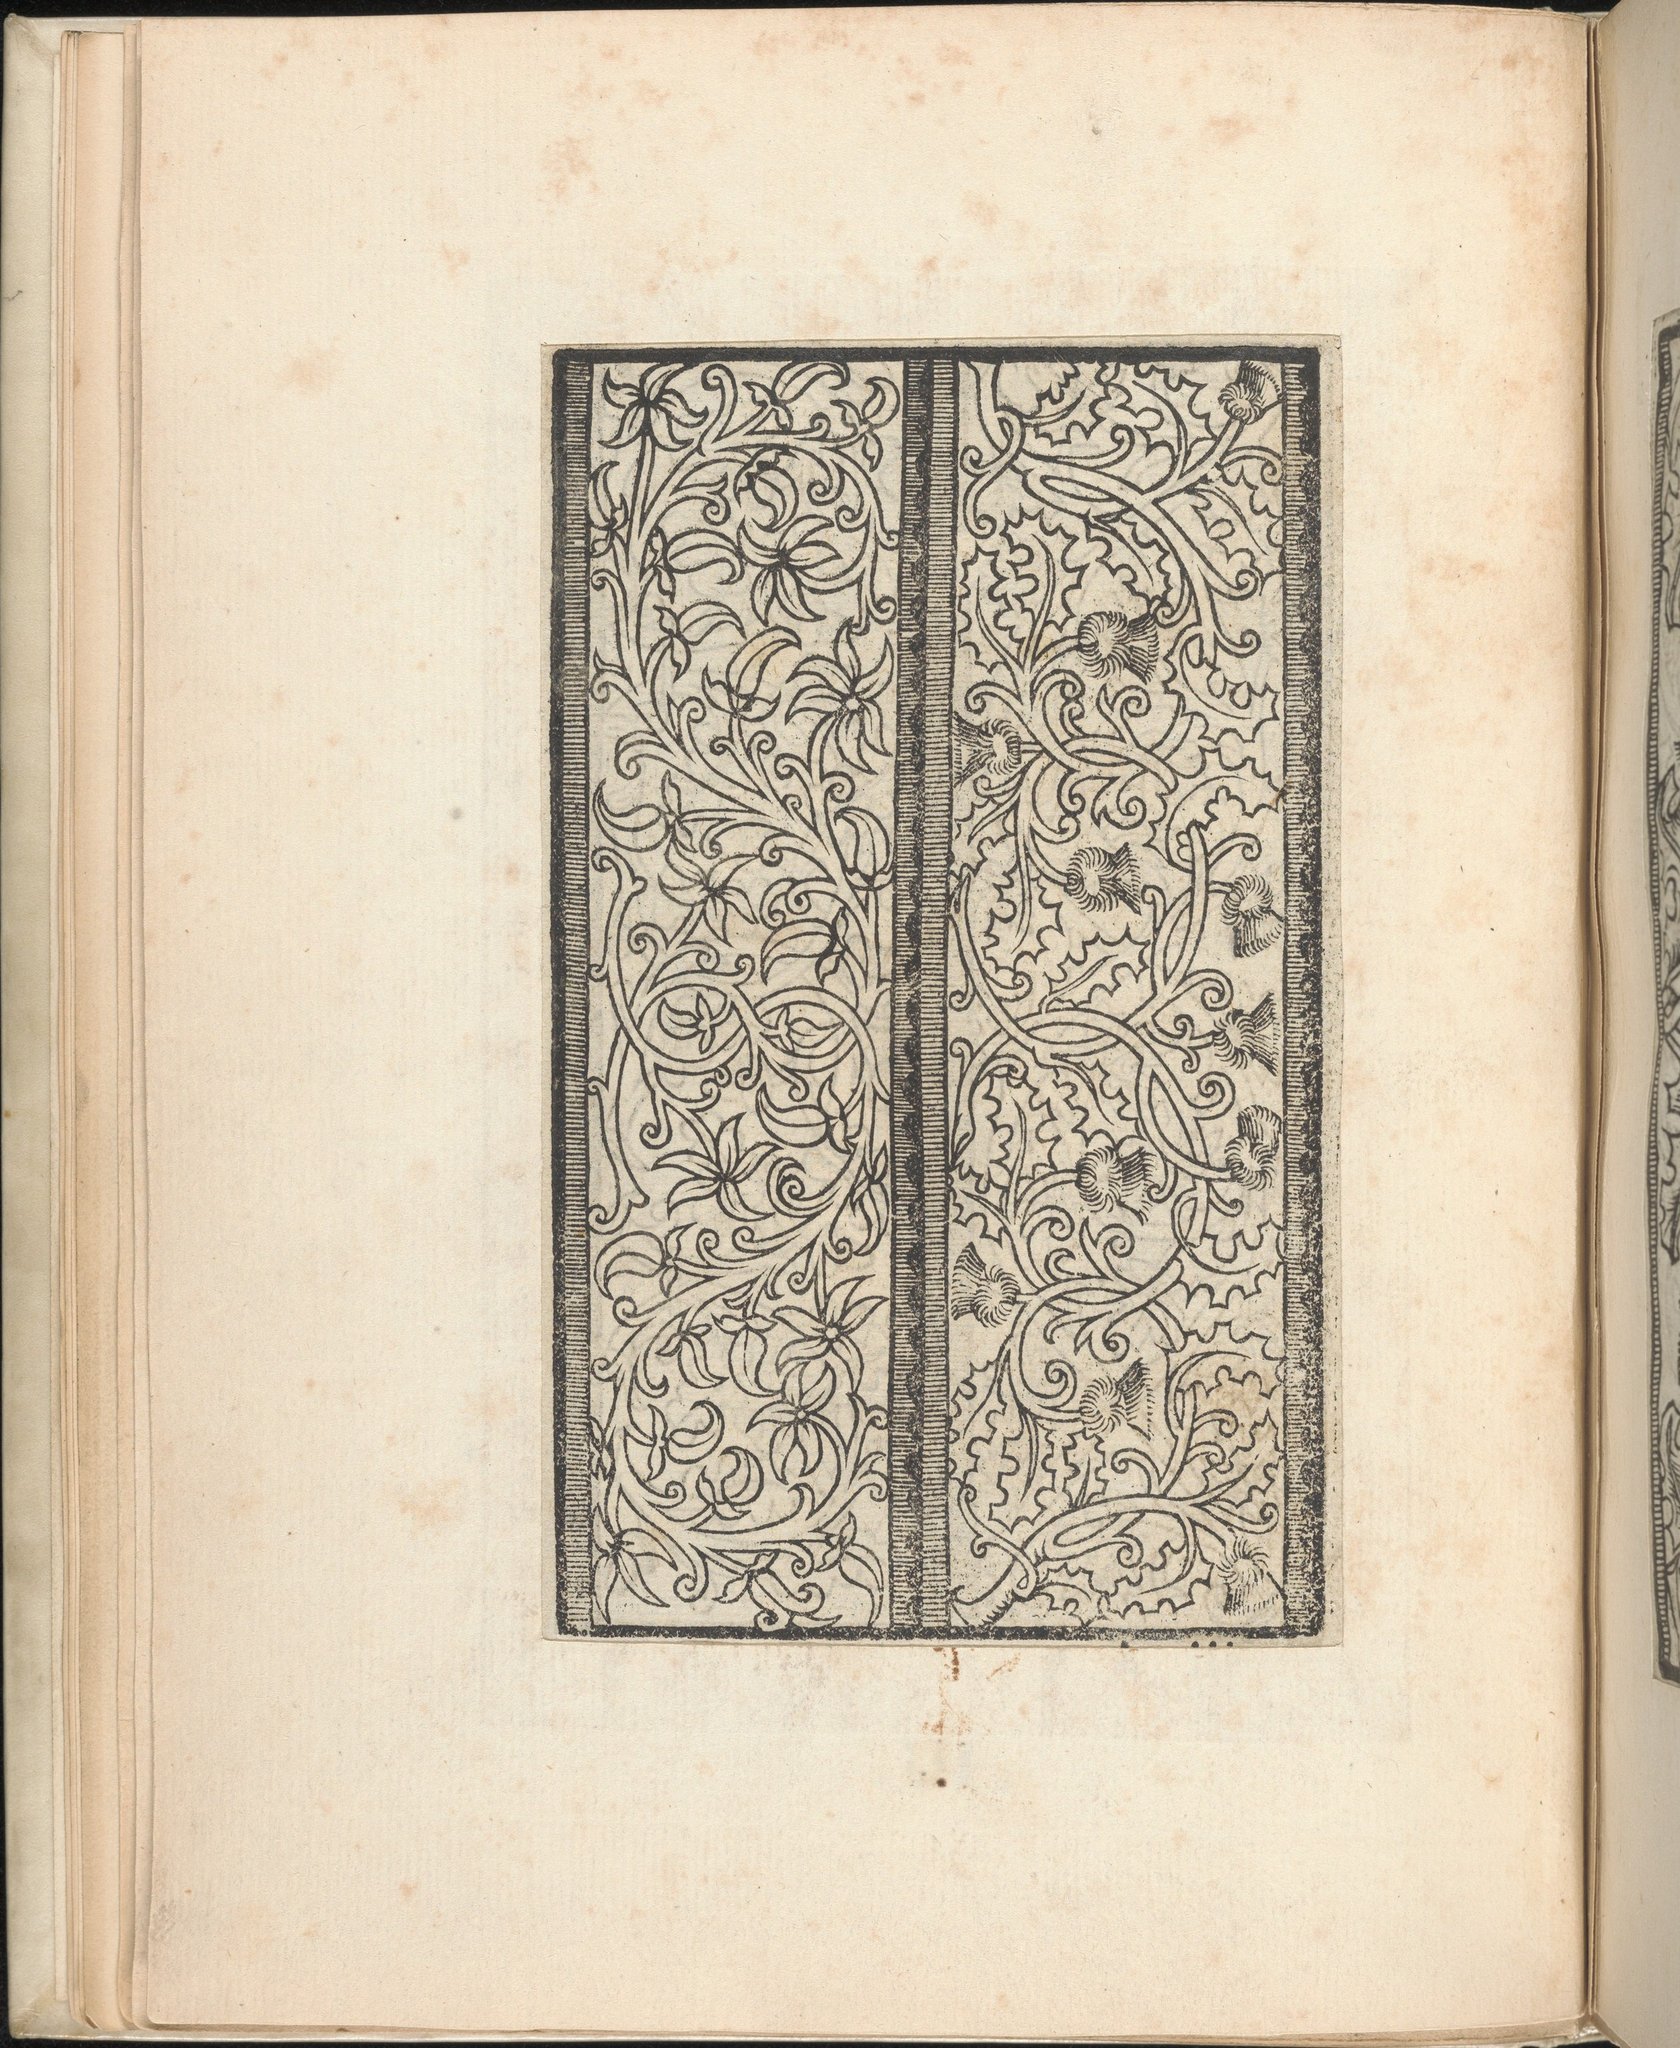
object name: book print ornament architecture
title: Esemplario di lavori, page 3 (verso)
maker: nicolò zoppino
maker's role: publisher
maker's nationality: italian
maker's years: 1478-1544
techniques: bookbinding, inlay, woodcut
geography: italy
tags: flowers,leaves